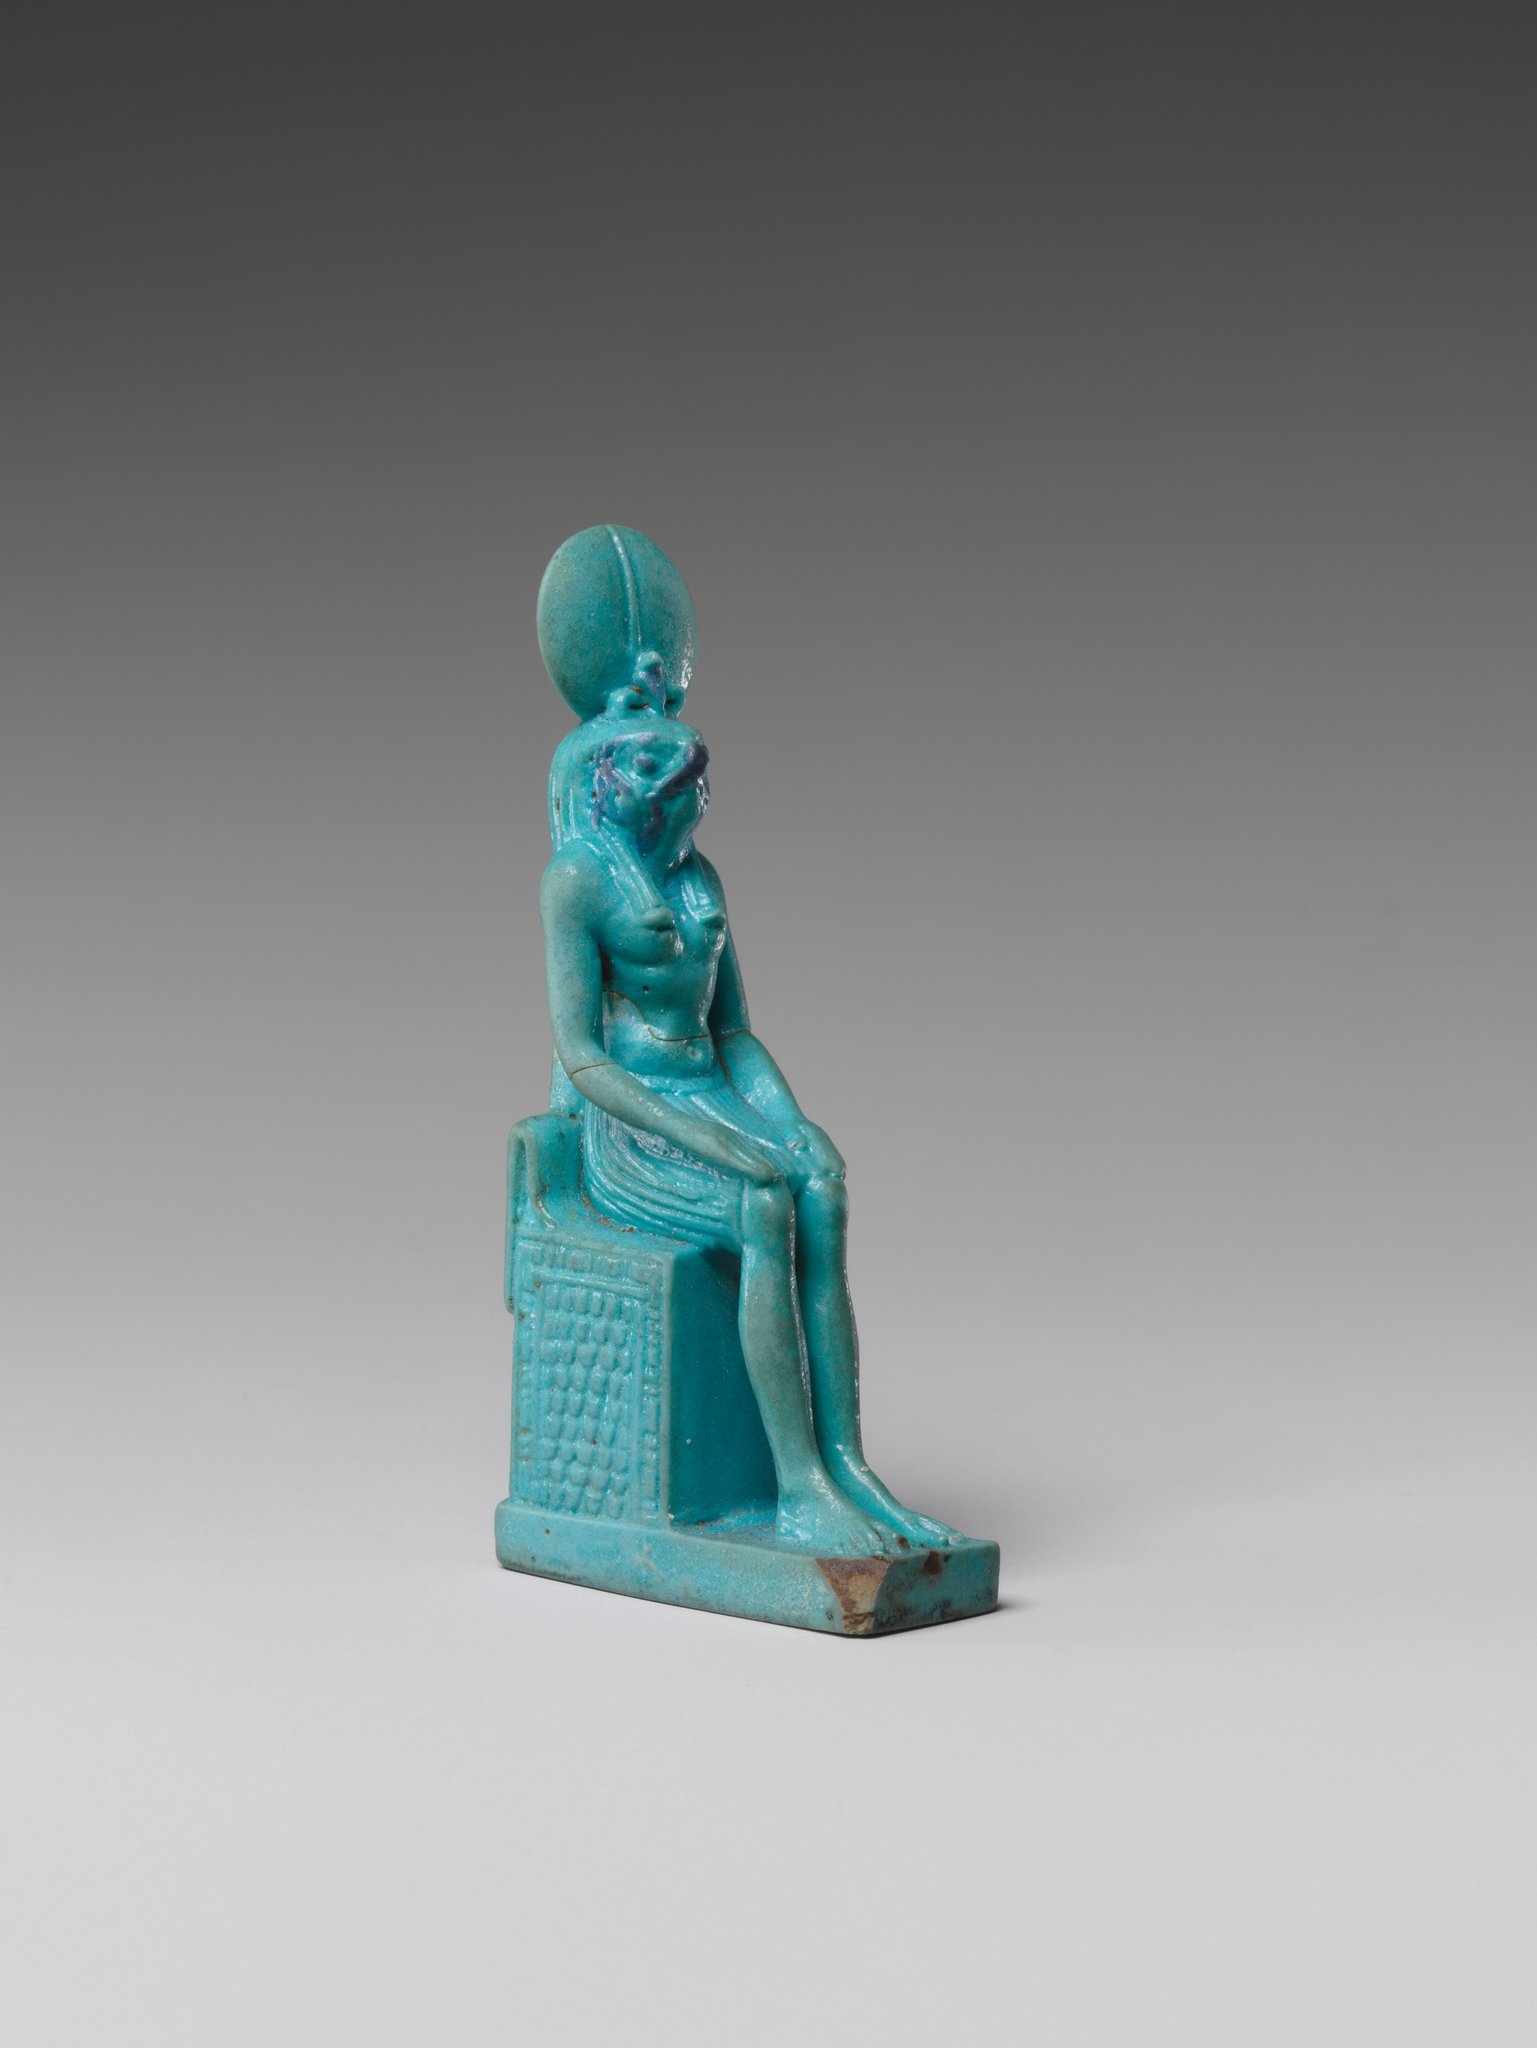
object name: re harakhty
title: Statuette of Re-Harakhty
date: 332-330 BCE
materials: faience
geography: egypt